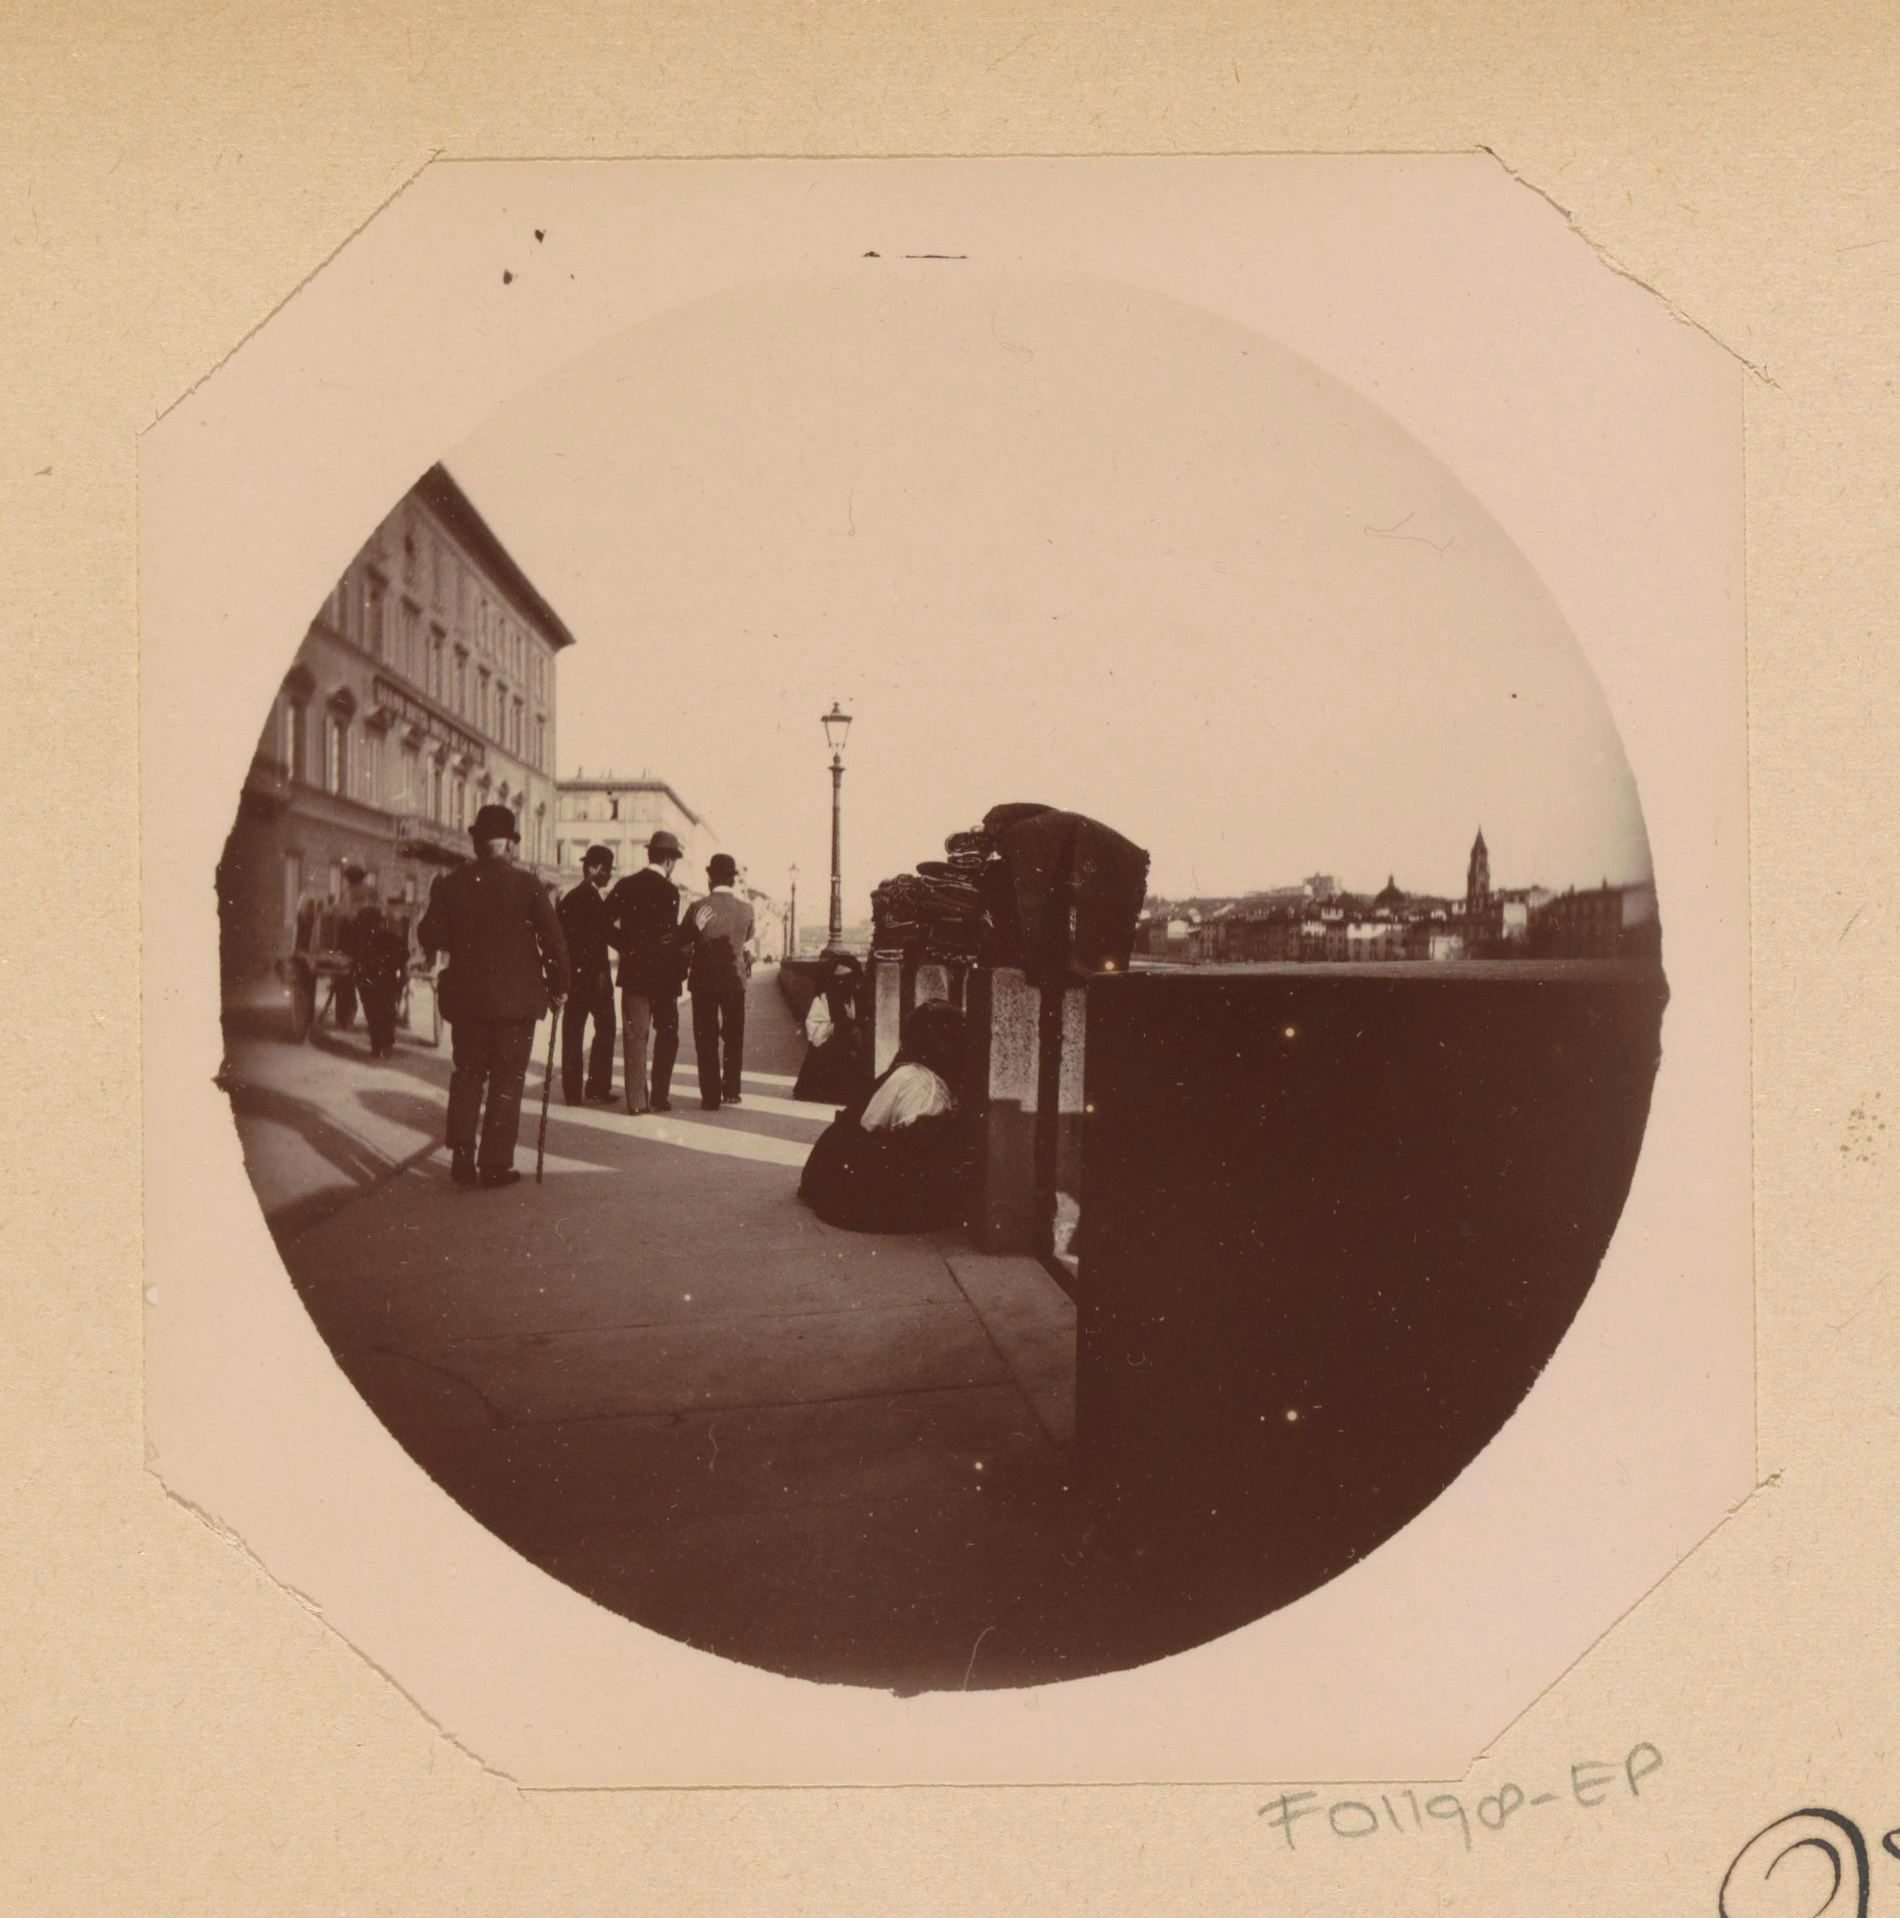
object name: photograph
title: Promenade met passanten langs de Arno in Florence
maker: johanna margaretha piek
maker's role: fotograaf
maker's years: 1870-1947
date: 1889-1893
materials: paper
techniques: gelatin silver print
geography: florence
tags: avenue, boulevard, promenade, esplanade